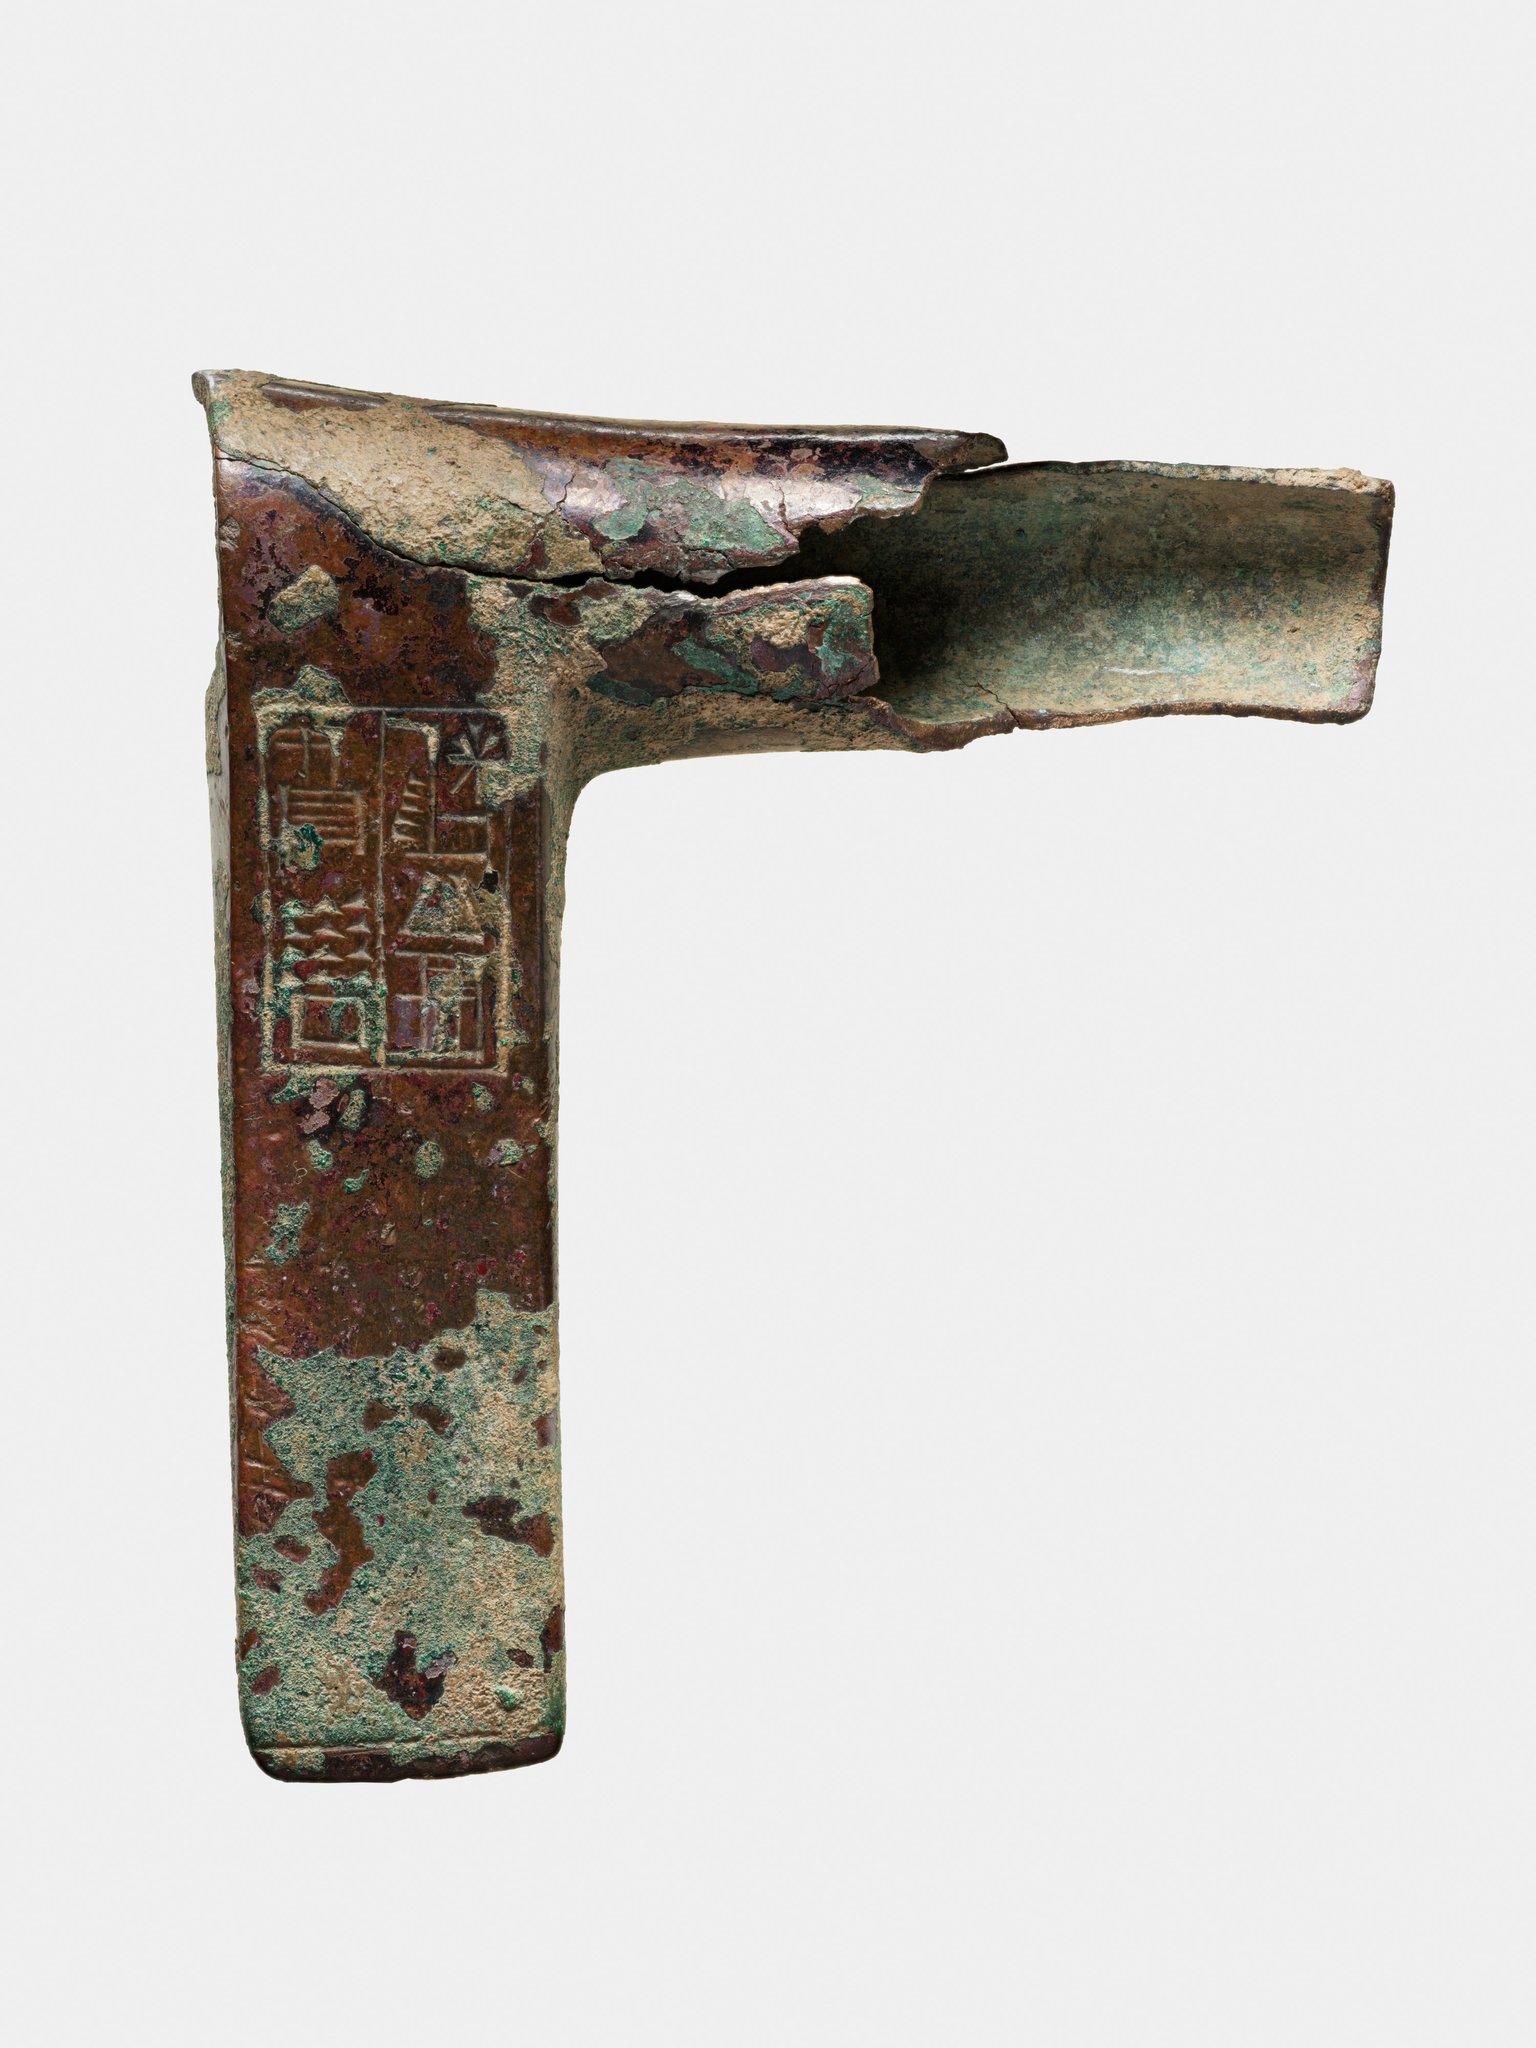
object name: axe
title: Axe head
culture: akkadian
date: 2350-2150 BCE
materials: copper alloy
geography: iran or mesopotamia